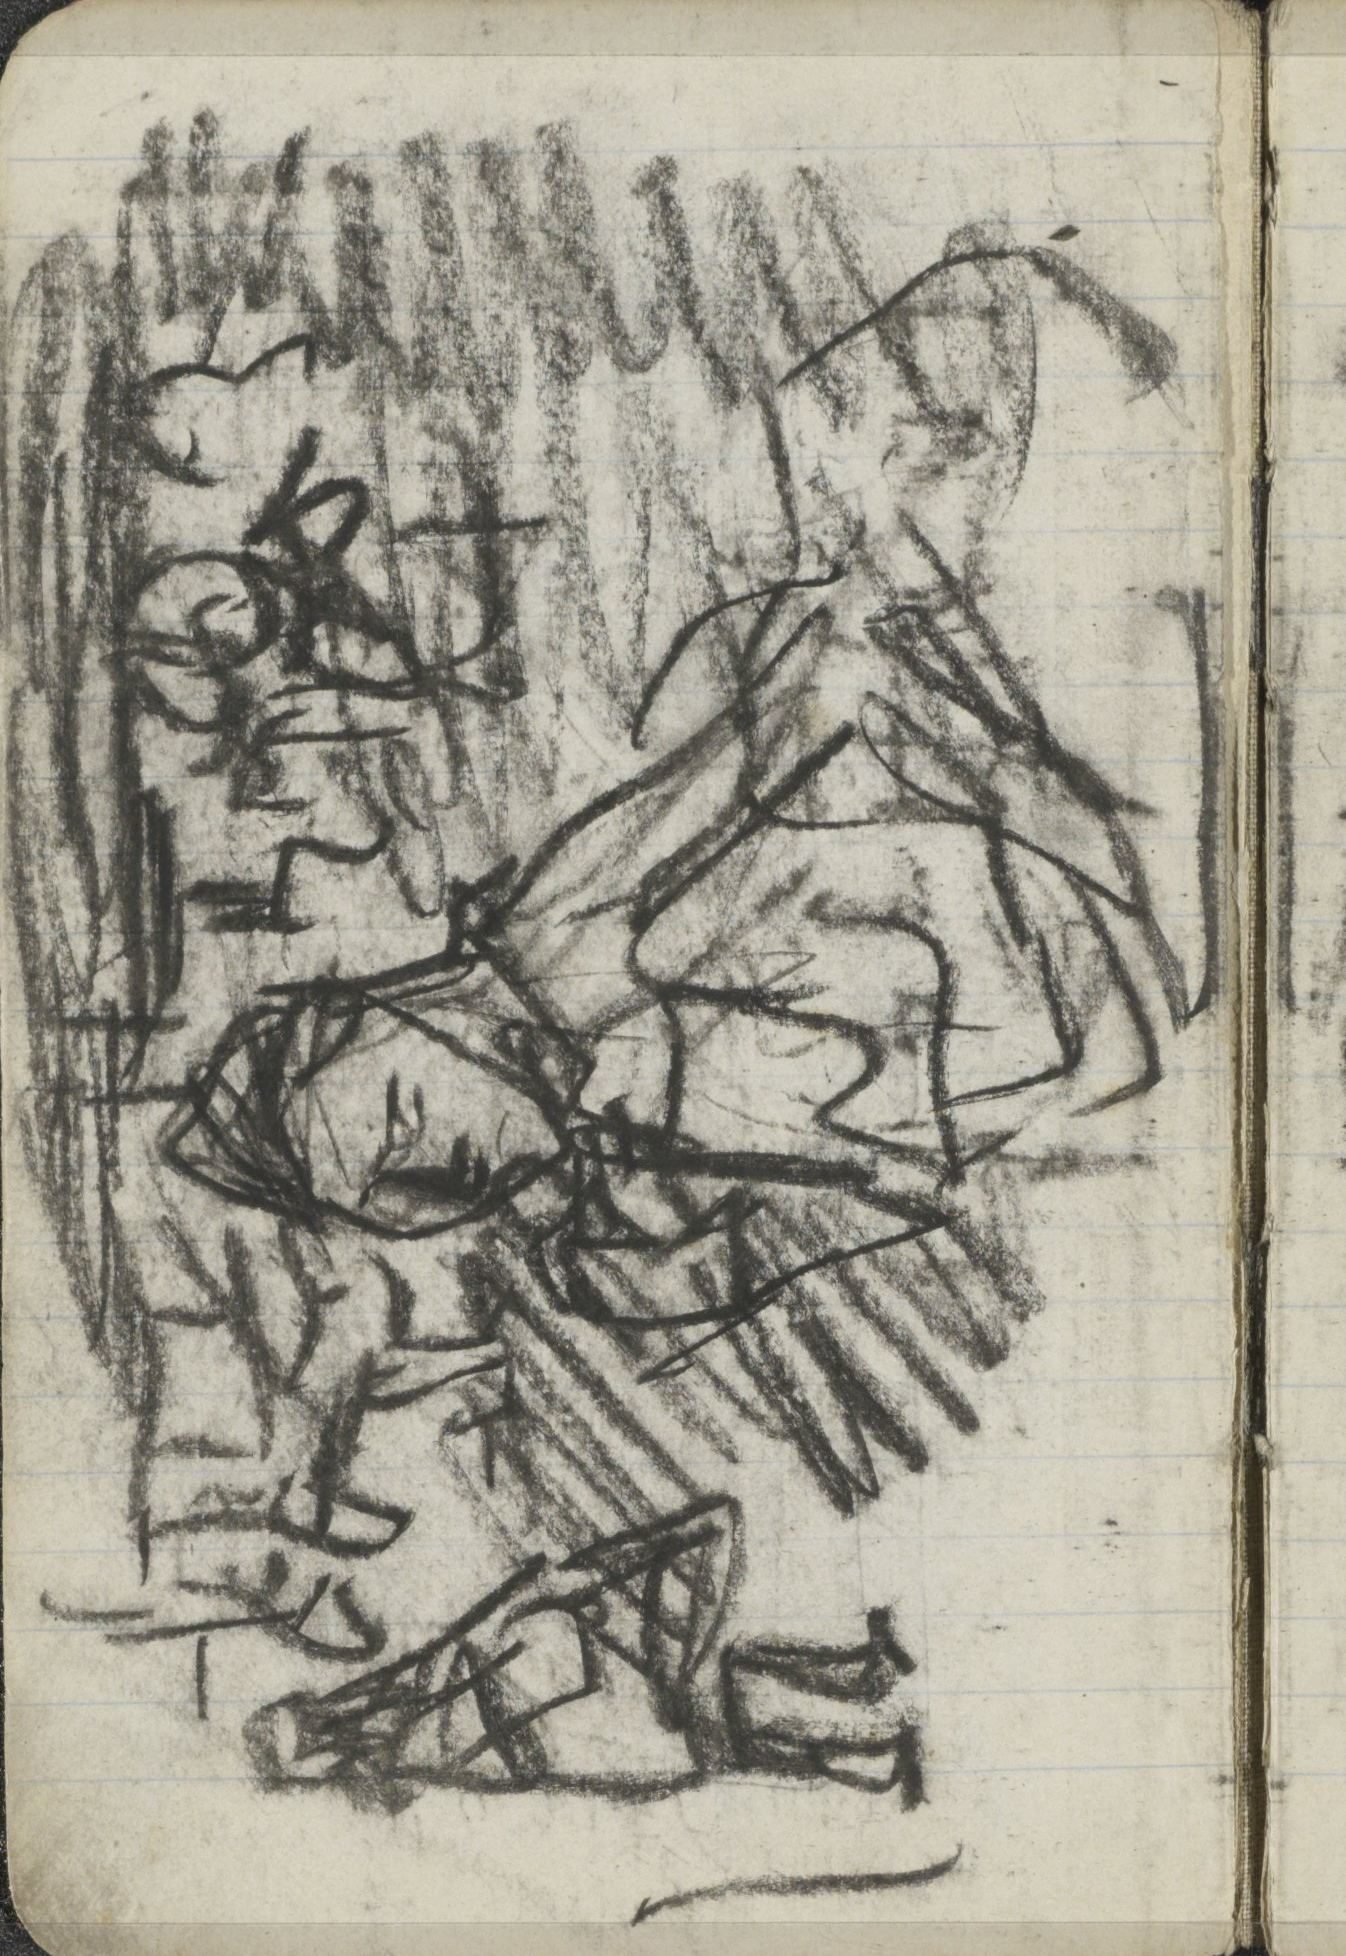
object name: sketchbook leaf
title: Figuren op de Dam in Amsterdam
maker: george hendrik breitner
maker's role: draughtsman, painter, print maker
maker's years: 1857-1923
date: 1893-1894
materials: chalk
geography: amsterdam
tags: diligence, omnibus, horse-tram, square, place, circus, etc. (+ city(-scape) with figures, staffage)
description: Op de achtergrond een paardentram. Pagina 4 uit een schetsboek met 36 bladen.